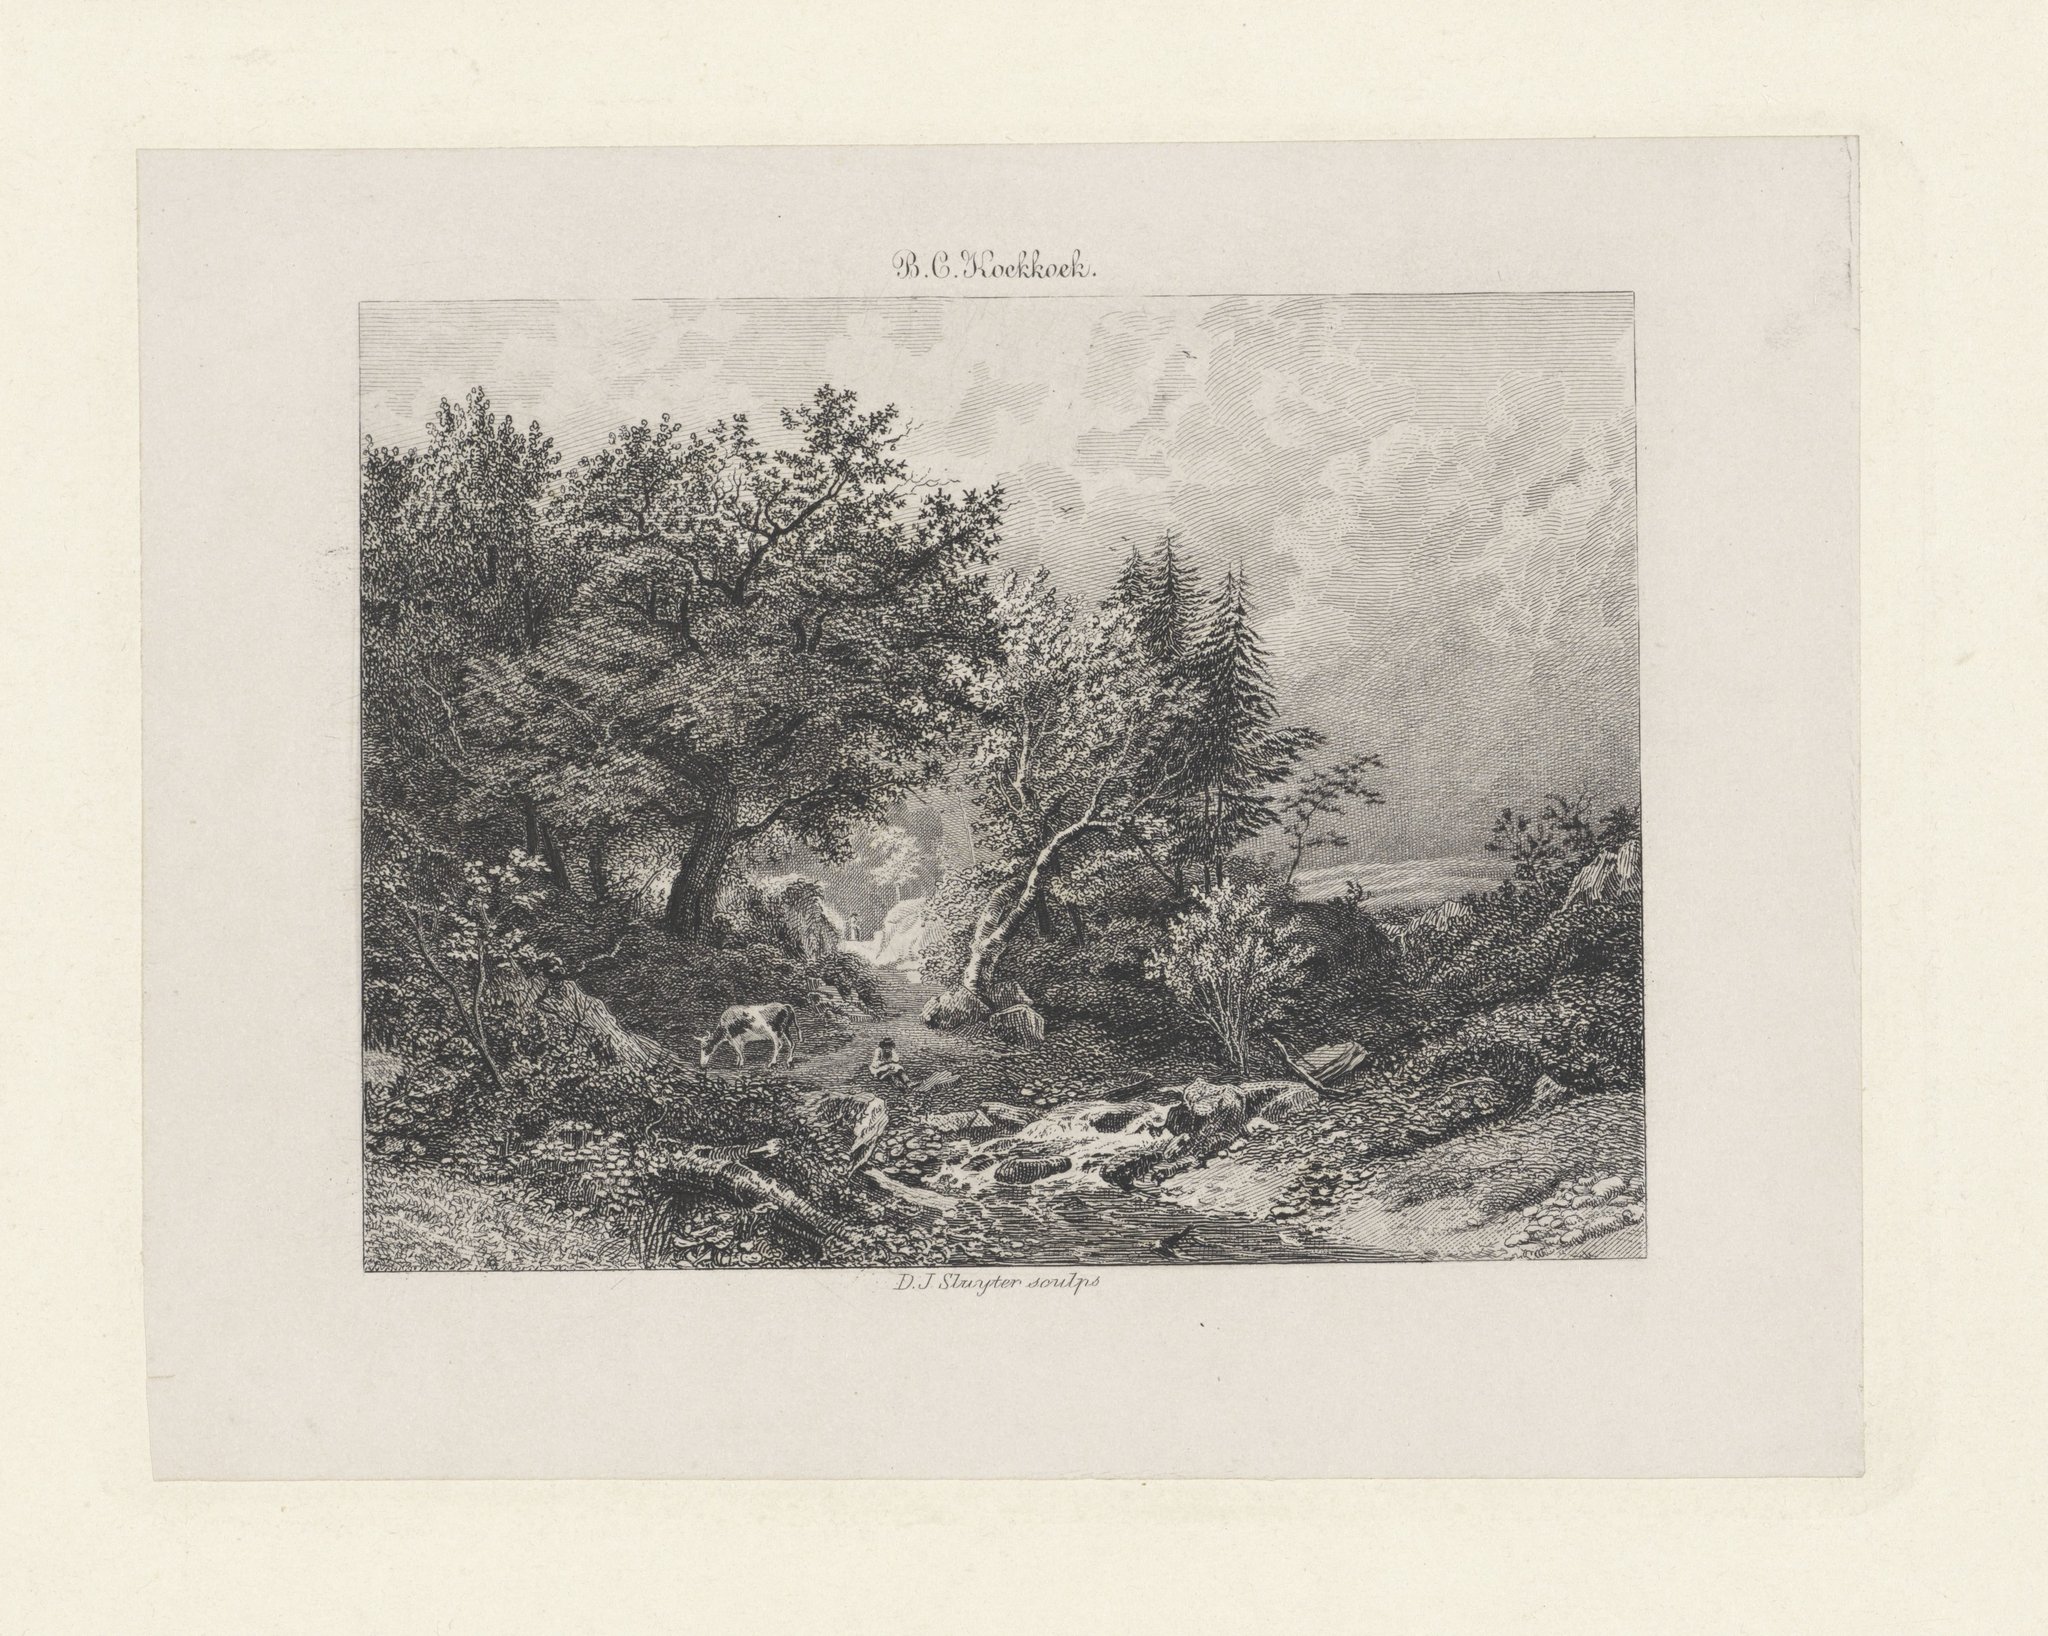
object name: print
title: Landschap met koe en herderin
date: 1826-1886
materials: paper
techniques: engraving, etching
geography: amsterdam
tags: landscapes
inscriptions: collector's mark: Lugt 2228